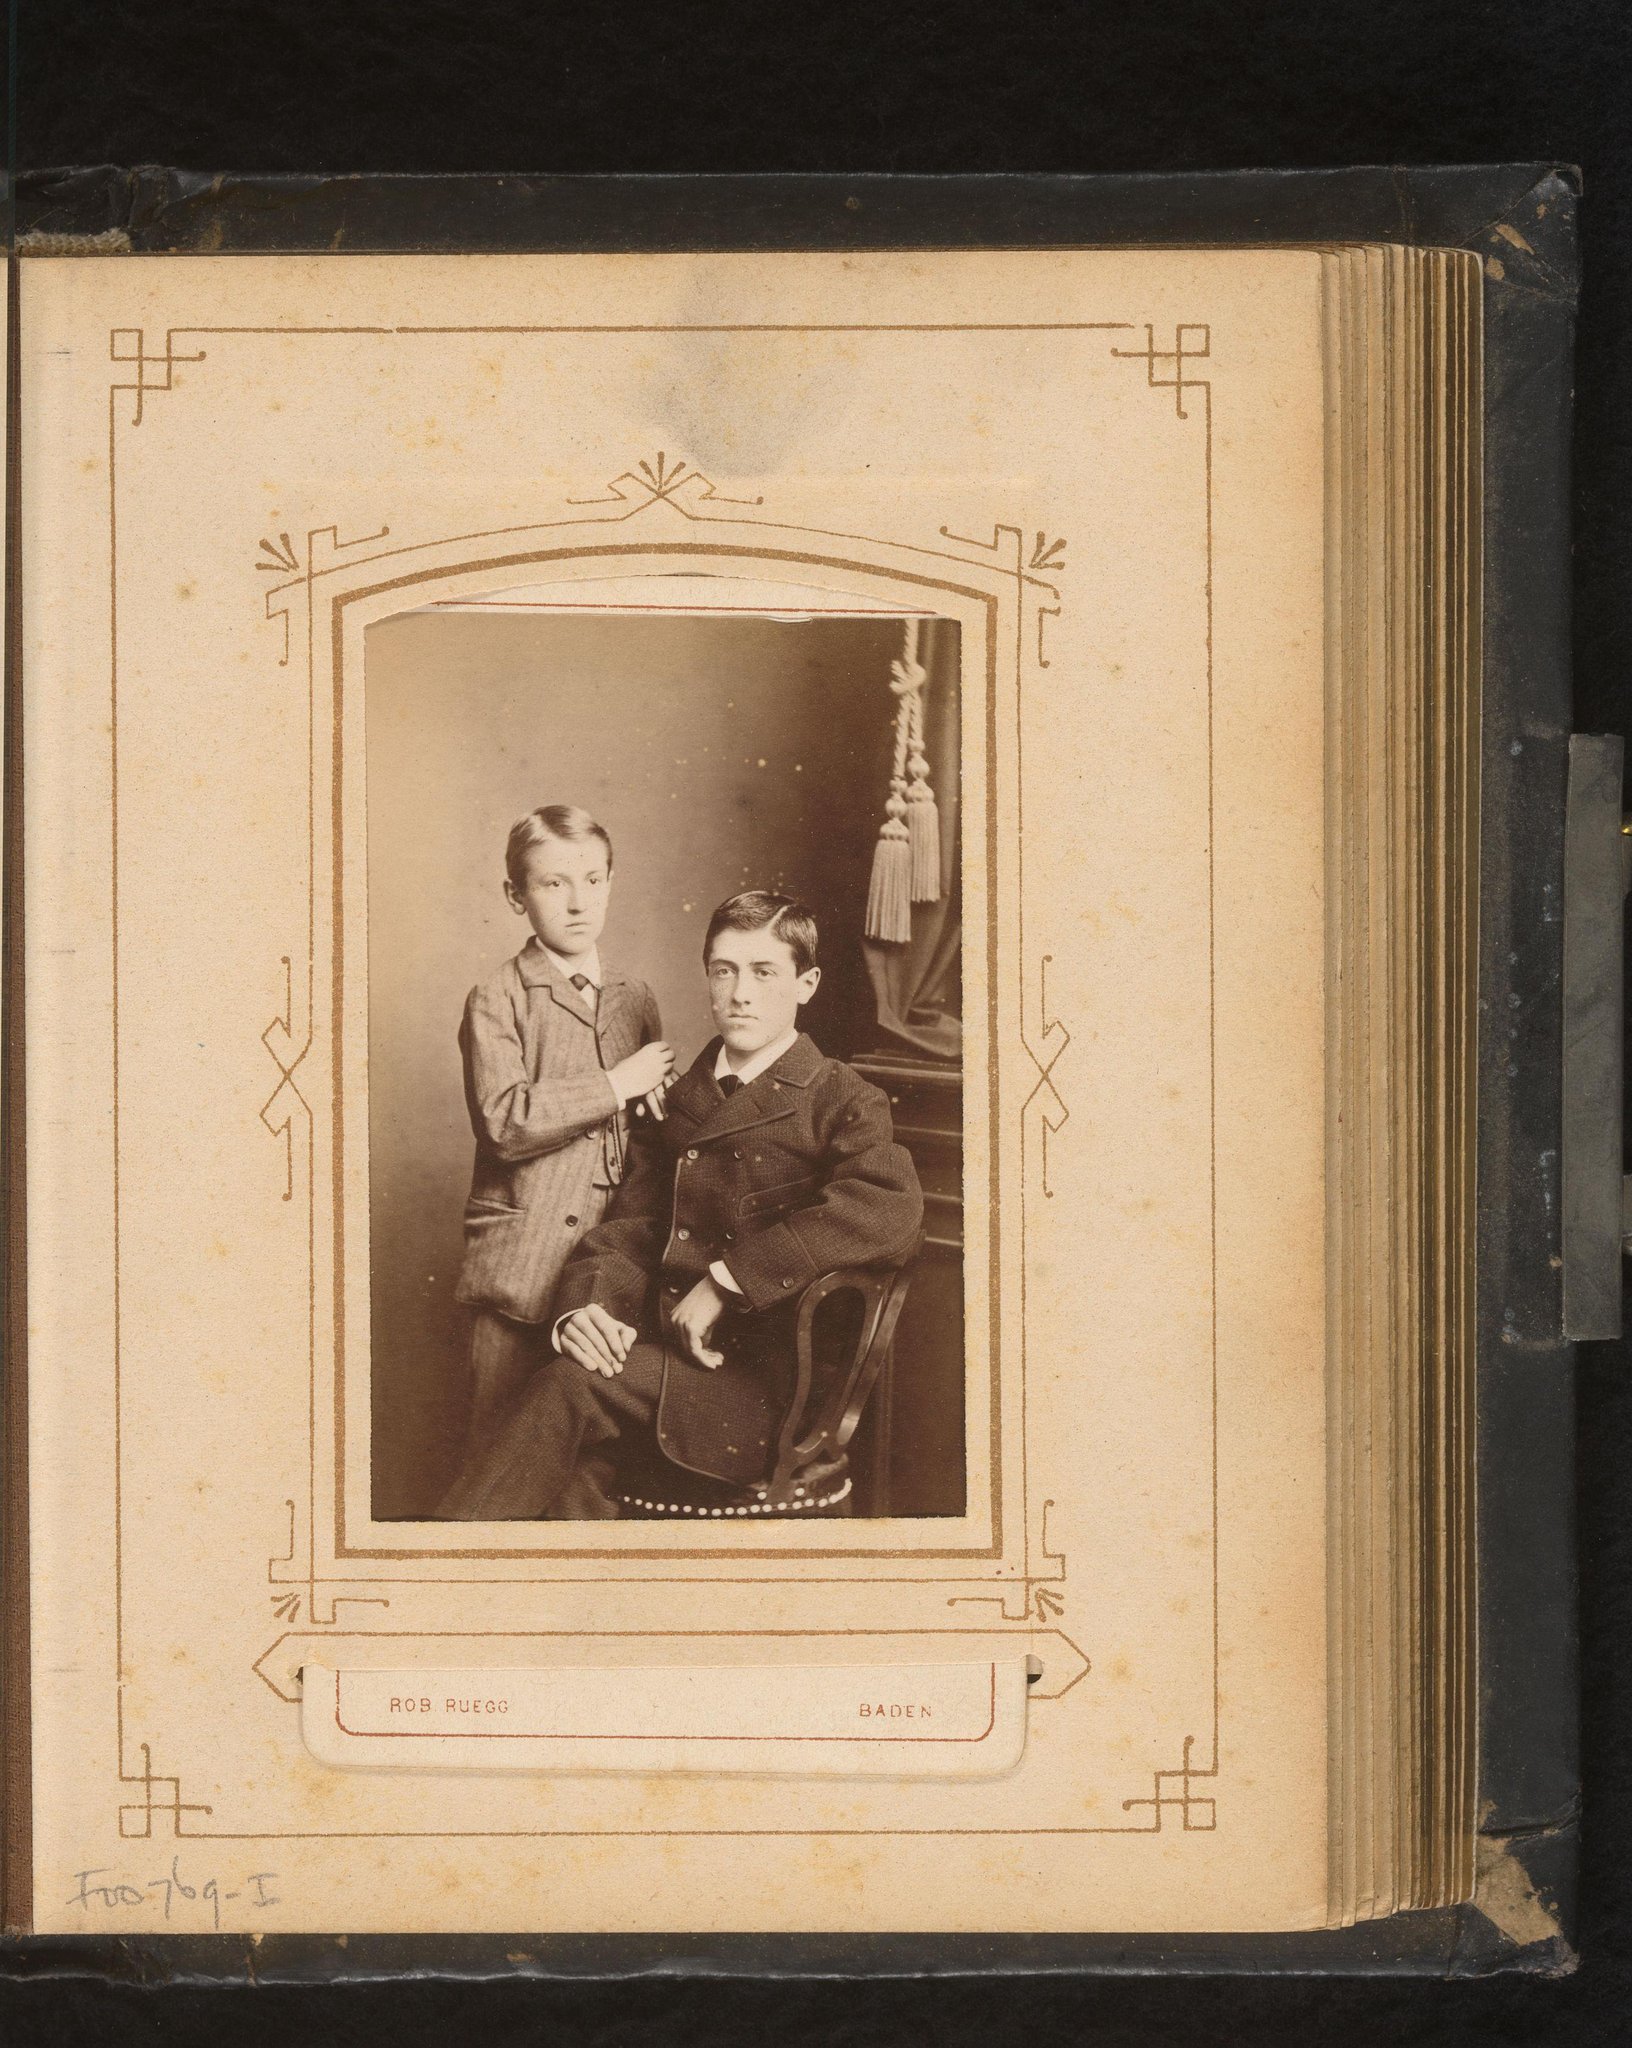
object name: album leaf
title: Portret van twee jongens, een staand en de ander zittend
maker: robert ruegg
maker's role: fotograaf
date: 1870-1900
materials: cardboard, photographic support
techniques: albumen print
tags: boy (child between toddler and youth), historical persons, chair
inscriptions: inscription: ‘Photographie/ Robert Ruegg/ Badstrasse No. 516/ Baden/ Schweiz (...)’